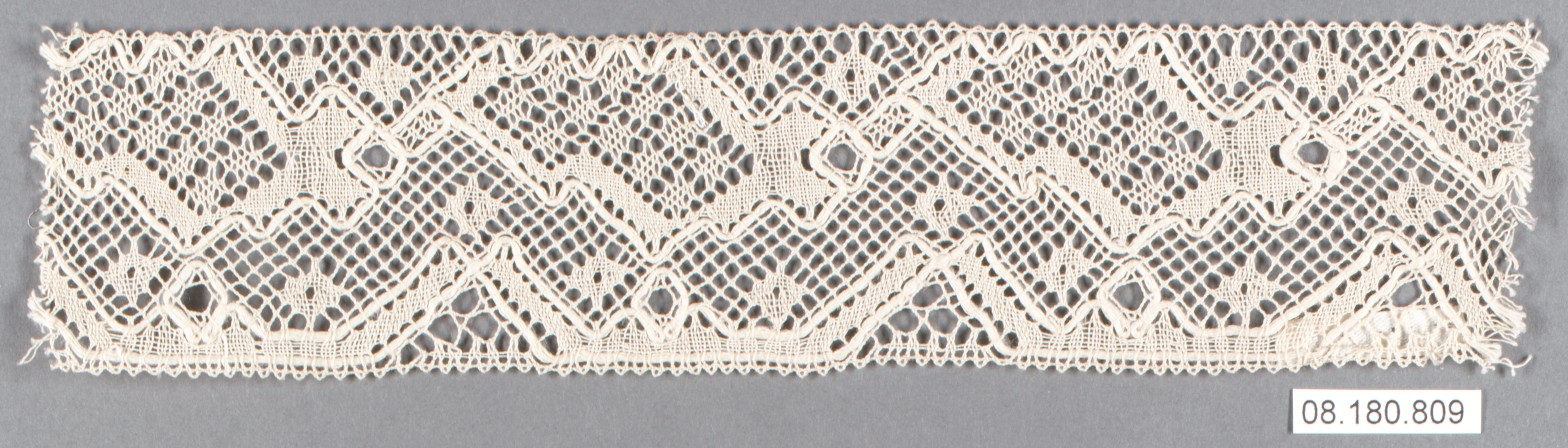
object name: fragment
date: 1801-1900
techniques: lace